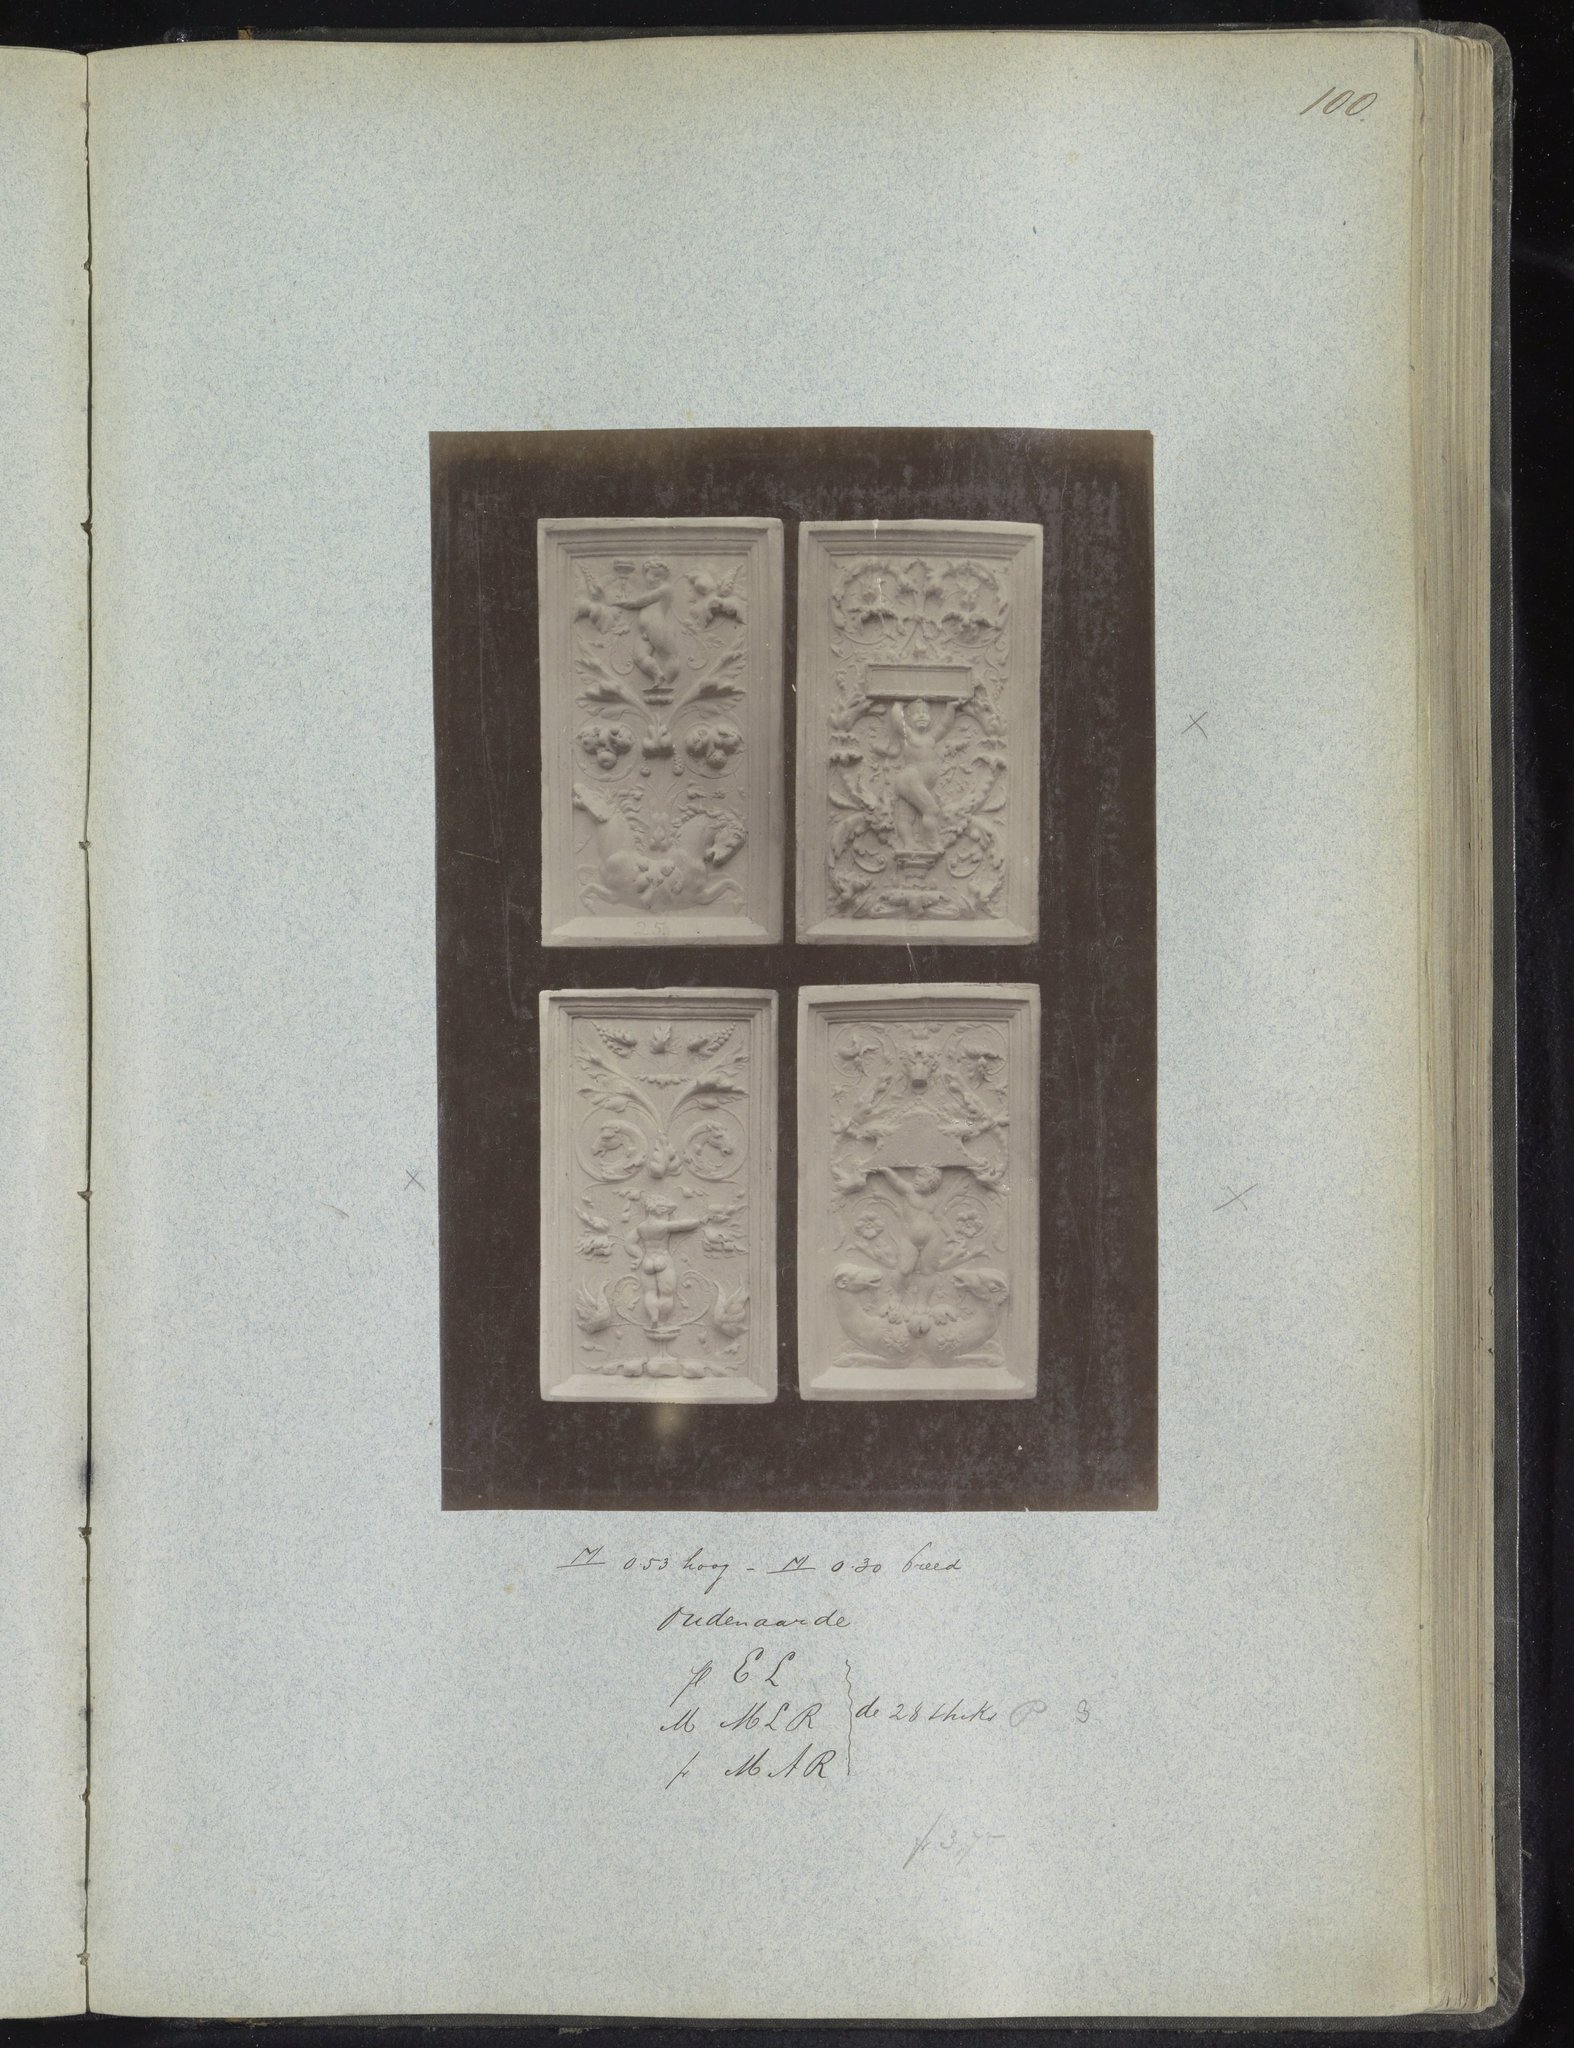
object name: album leaf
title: Vier gipsen afgietsels van panelen, vermoedelijk afkomstig uit Oudenaarde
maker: Anonymous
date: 1875-1900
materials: paper, photographic support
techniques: albumen print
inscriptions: annotation, annotation: ‘Oudenaarde’, annotation: ‘M 0.53 hoog - M 0.30 breed’